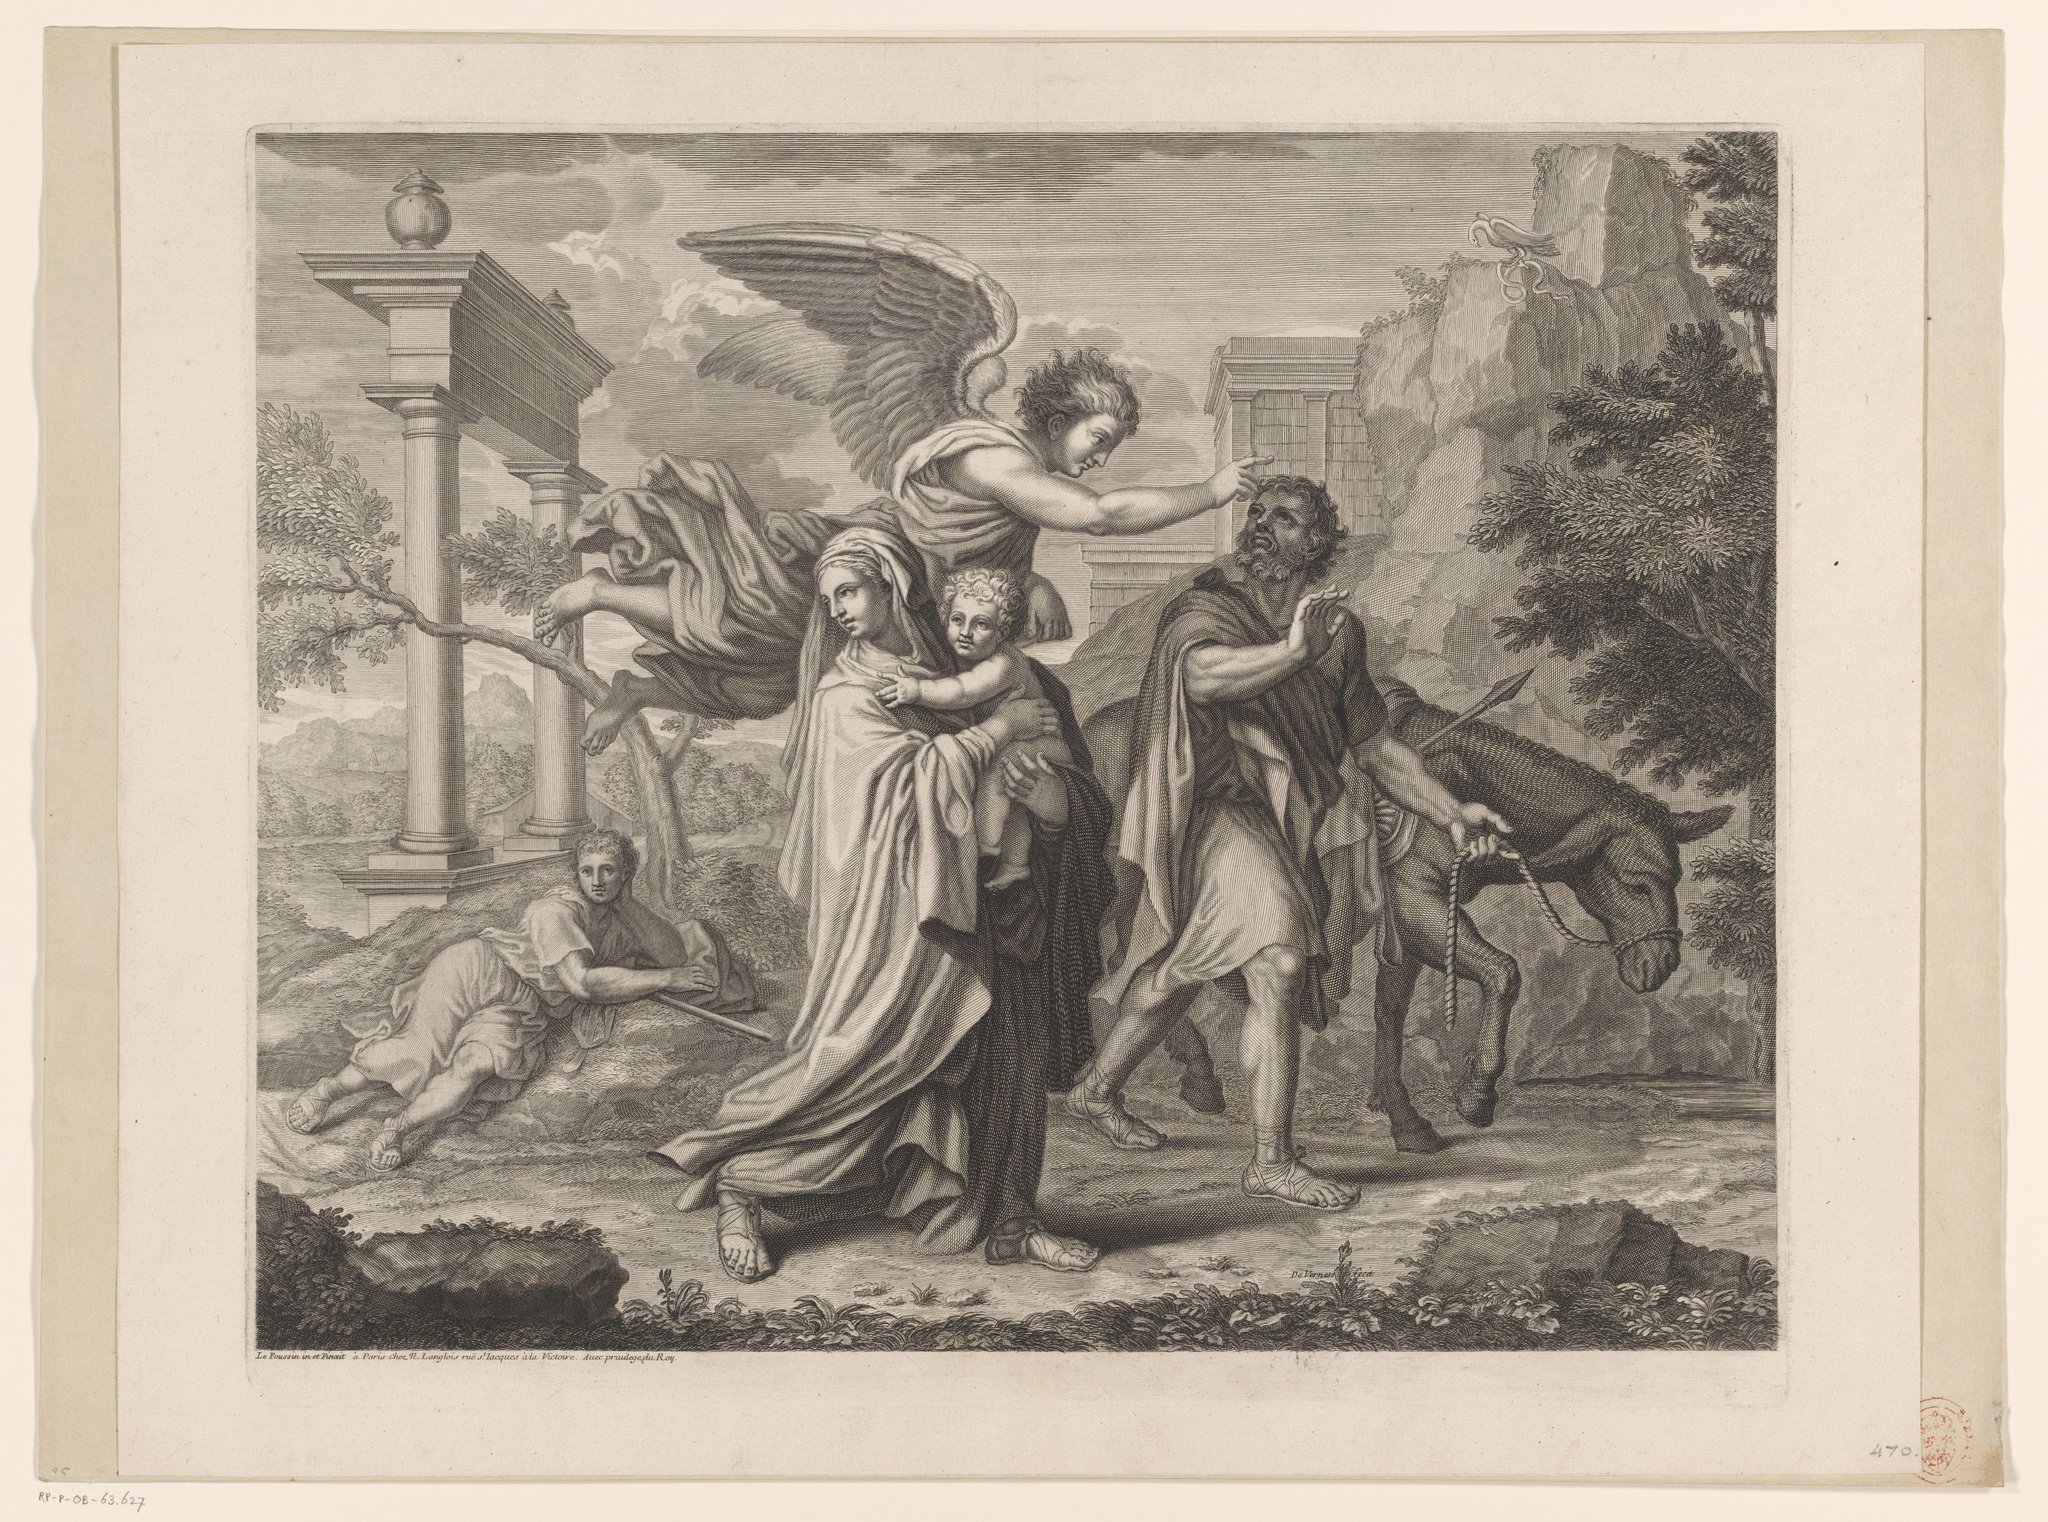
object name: print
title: Vucht naar Egypte met engel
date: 1650-1707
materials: paper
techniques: engraving, etching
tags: the flight into egypt: mary, joseph, the child (and sometimes others) on their way; mary usually riding on an ass, holy family, and derived representations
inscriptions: collector's mark: Lugt 240, number: ‘24’, number: ‘470’